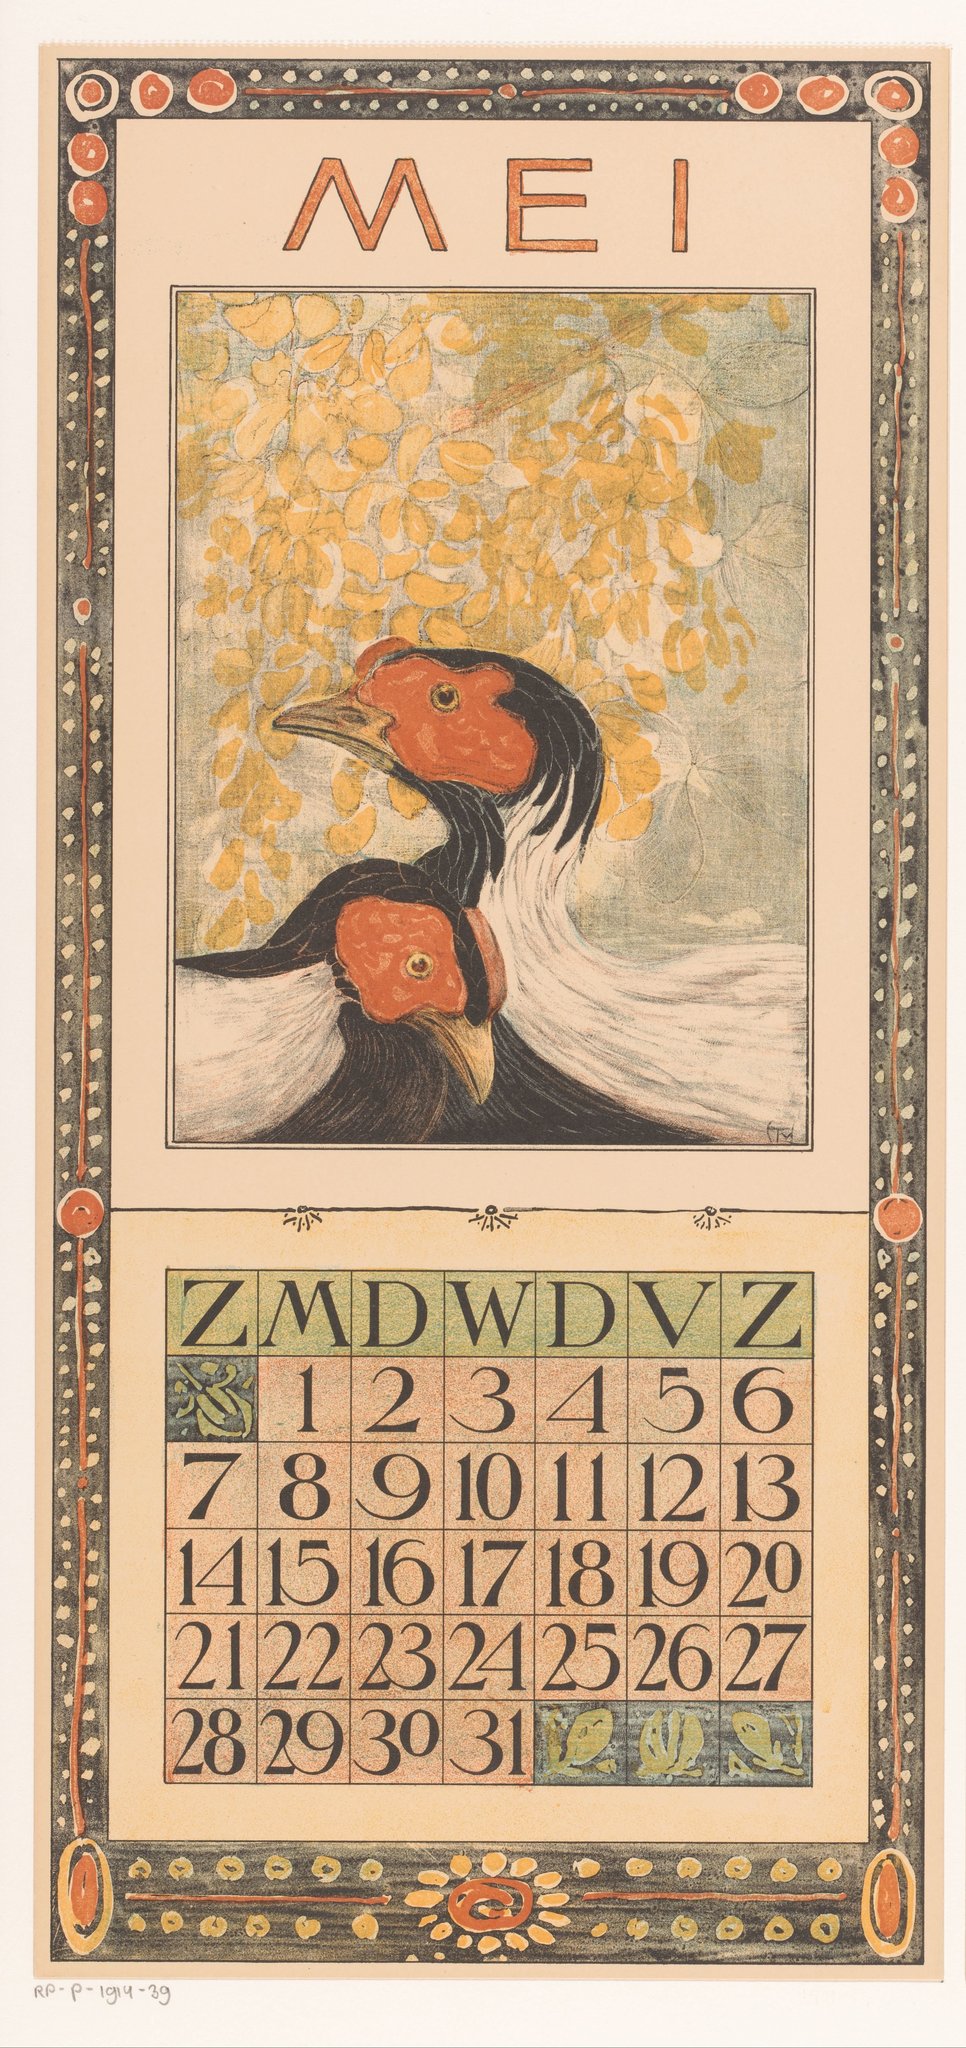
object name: print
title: Kalenderblad mei met zilverfraisanten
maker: theo van hoytema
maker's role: draughtsman, painter, print maker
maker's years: 1863-1917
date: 1904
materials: paper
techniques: lithograph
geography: amsterdam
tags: walker and runner birds: pheasant, may ~ other concepts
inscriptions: collector's mark: Lugt 2228